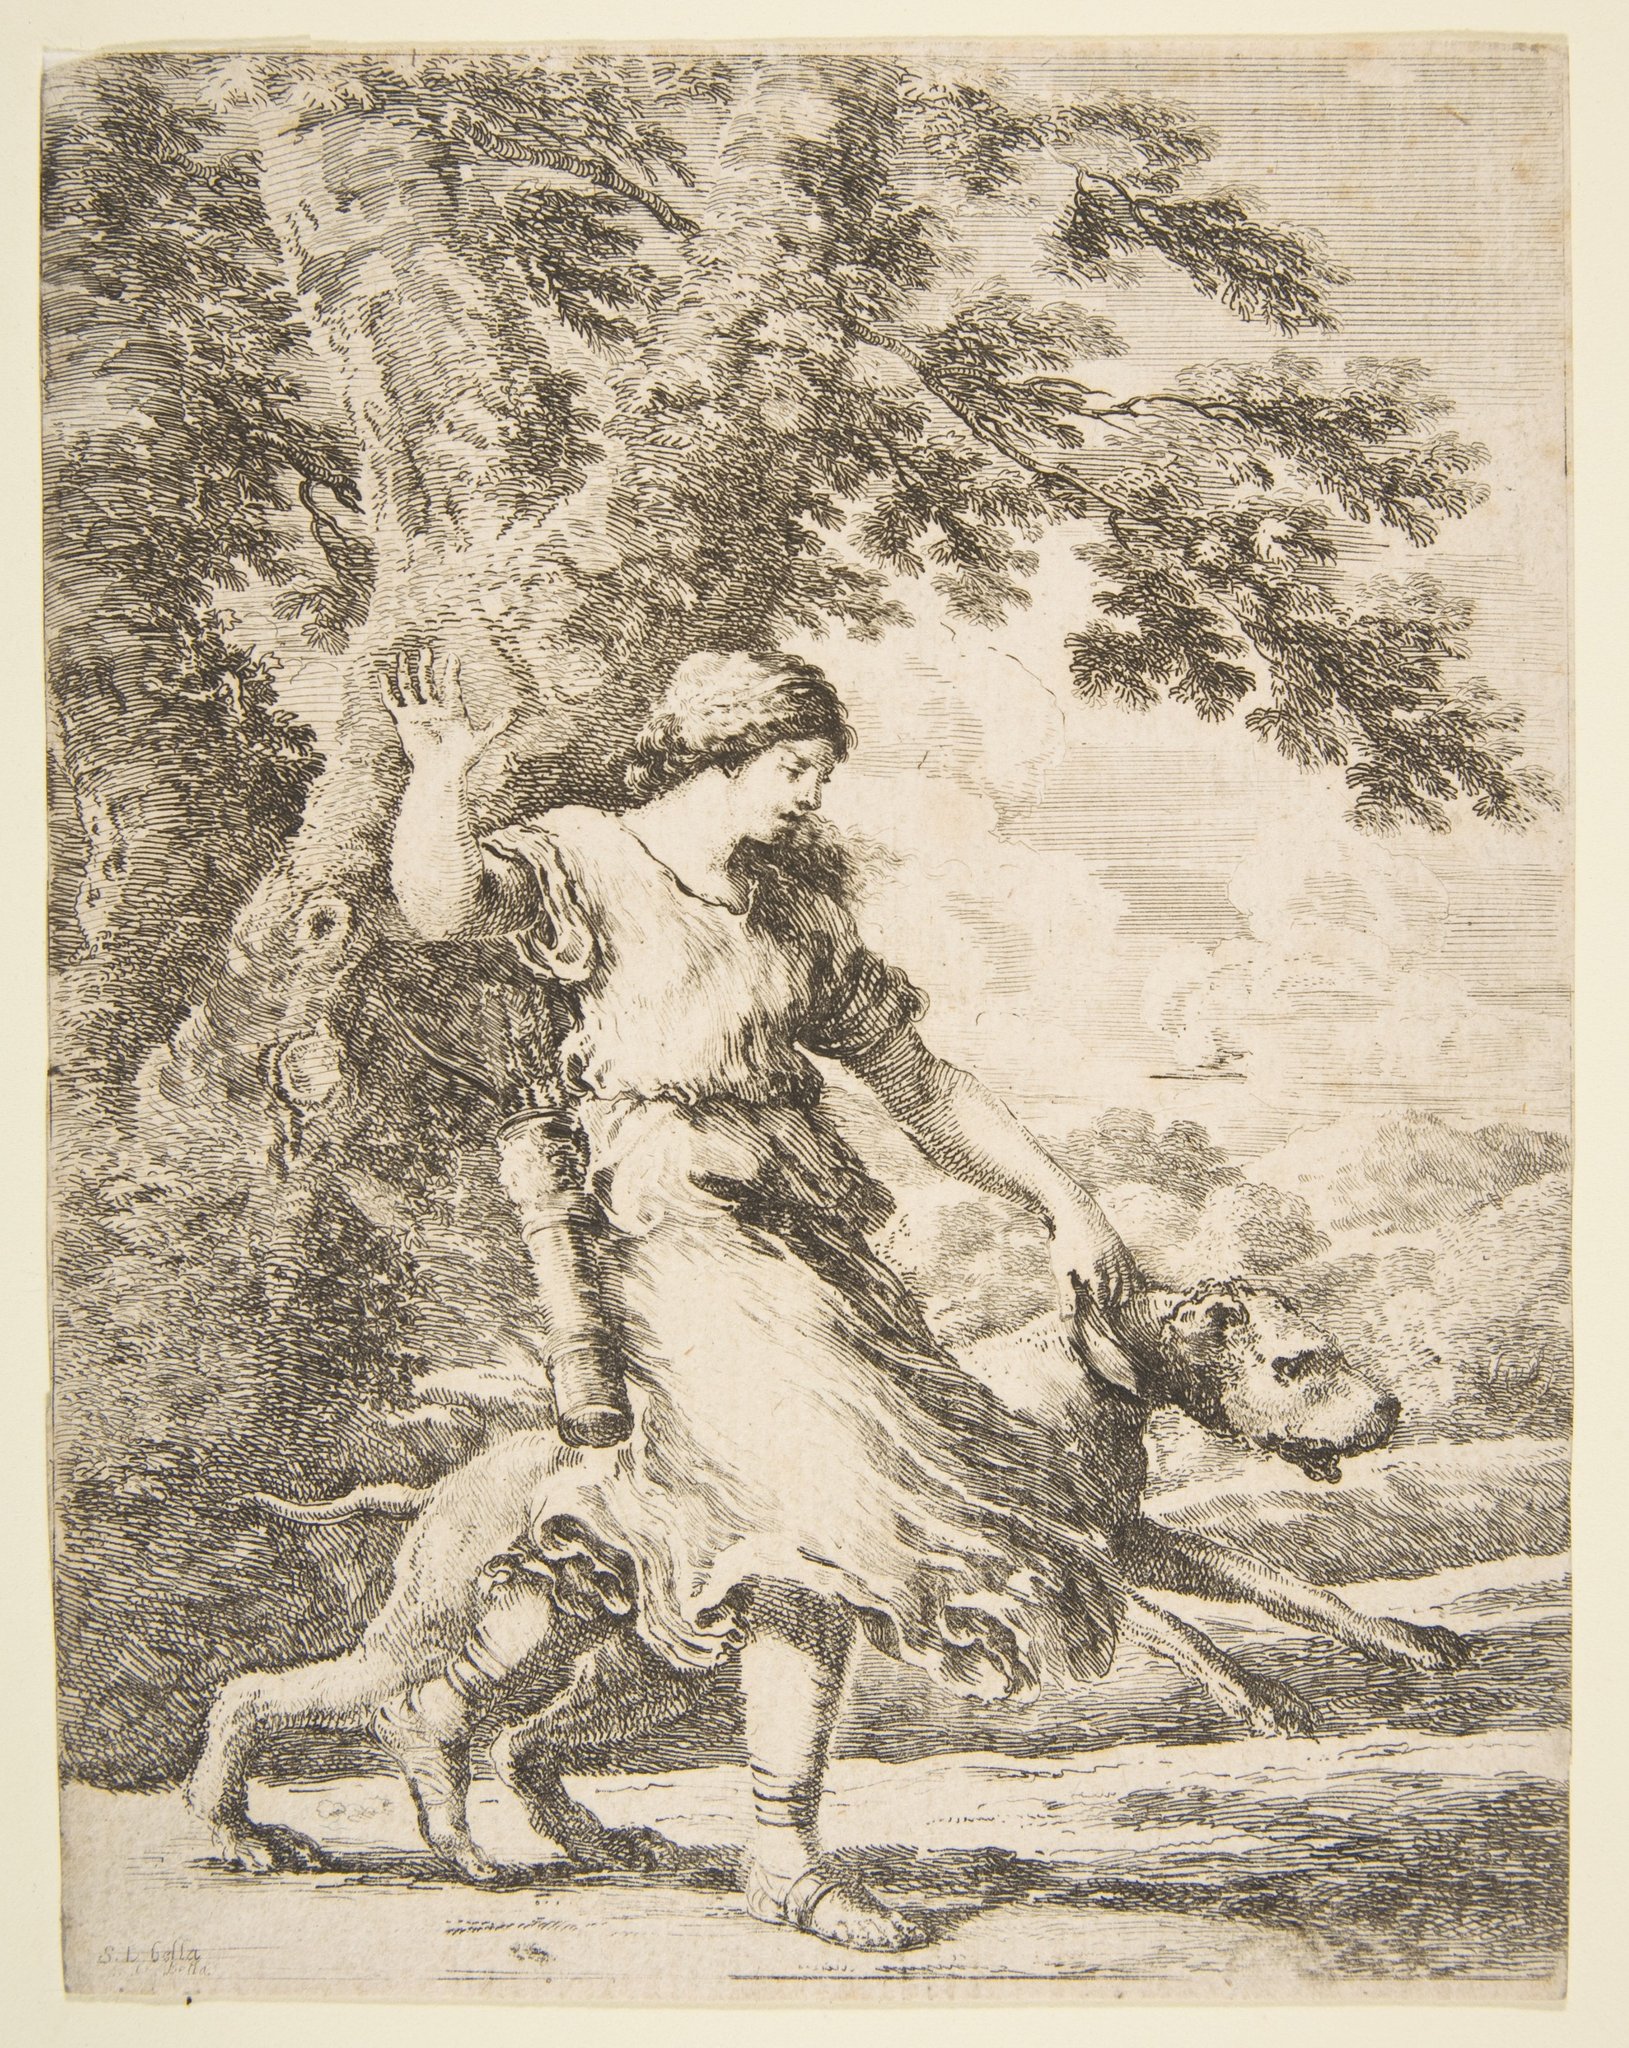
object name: print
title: Nymph Holding a Large Dog by the Collar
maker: stefano della bella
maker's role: artist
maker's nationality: italian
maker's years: 1610-1664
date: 1654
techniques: etching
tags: nymphs,dogs,trees